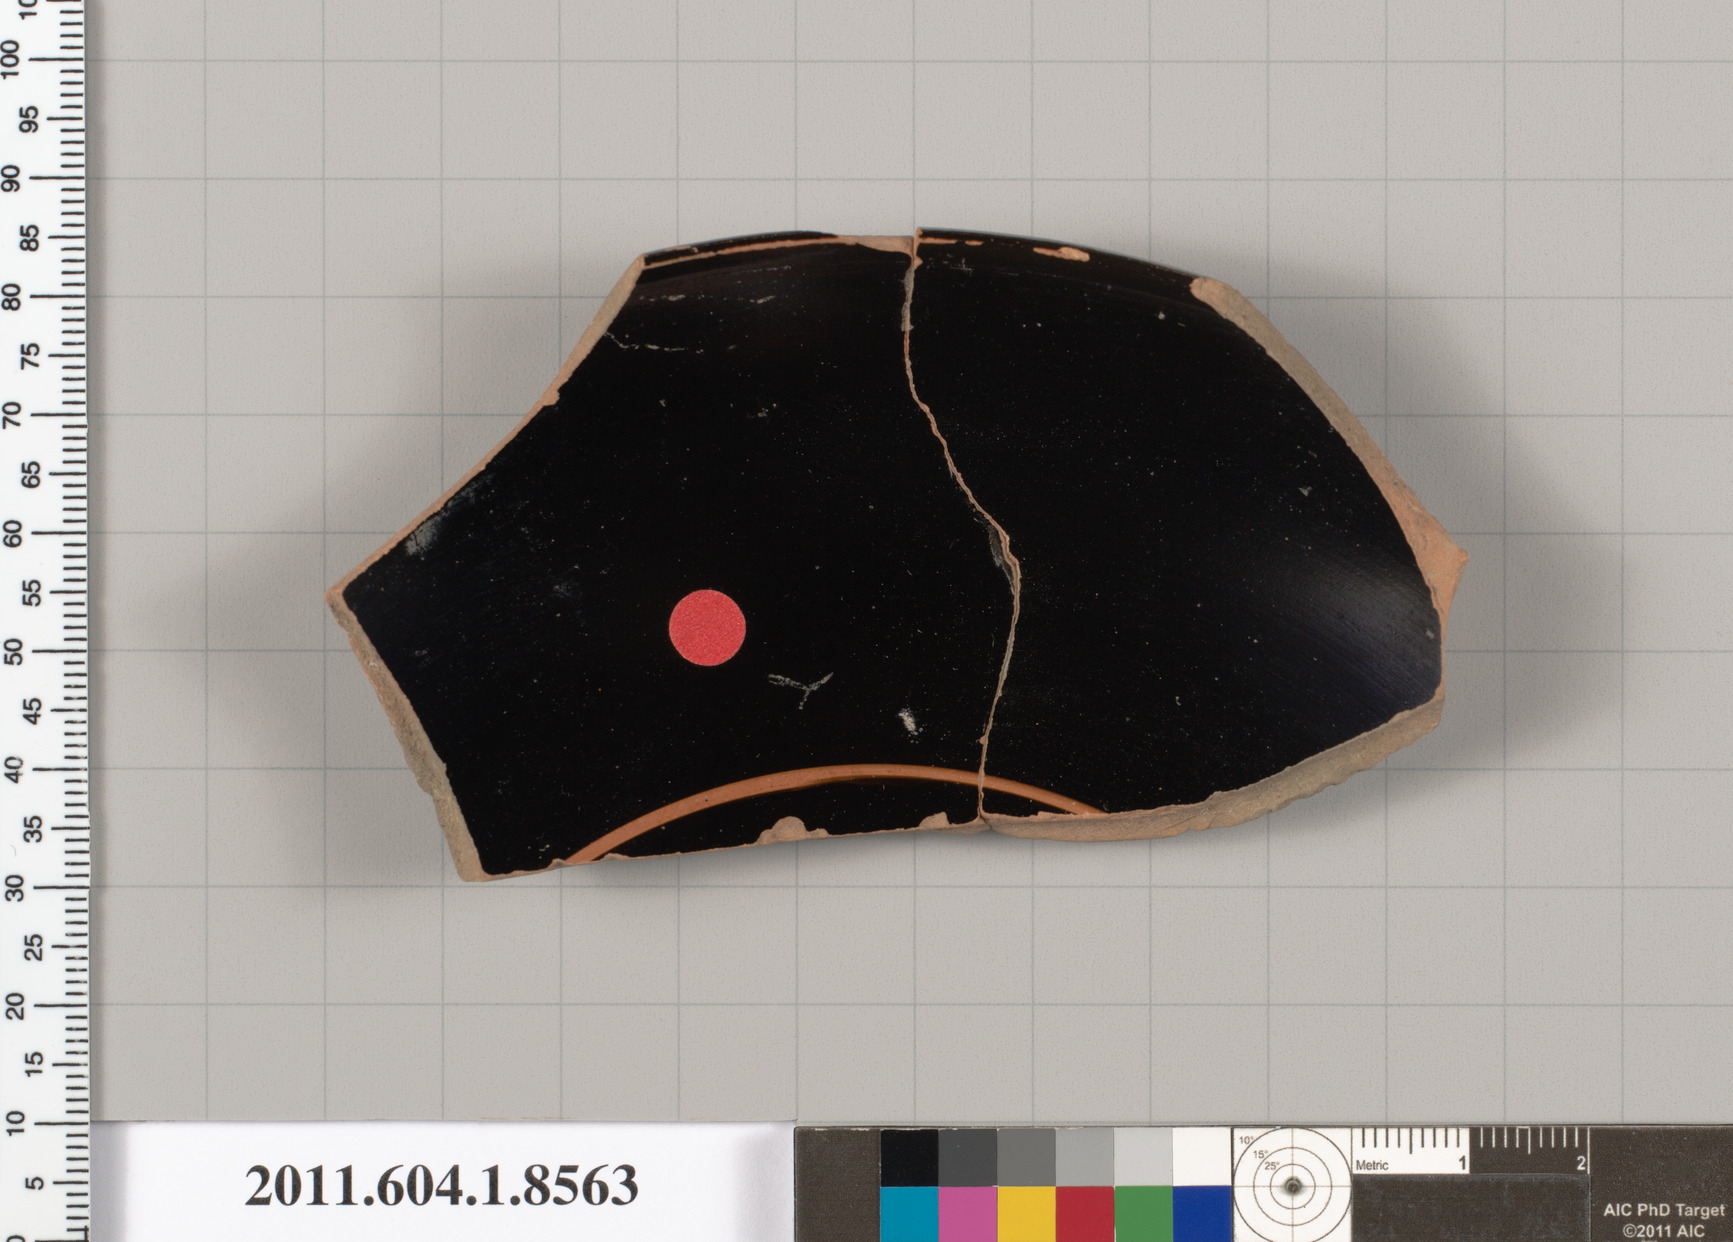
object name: kylix fragment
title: Terracotta rim fragment of a stemless kylix (drinking cup)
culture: greek, attic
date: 470-450 BCE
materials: terracotta